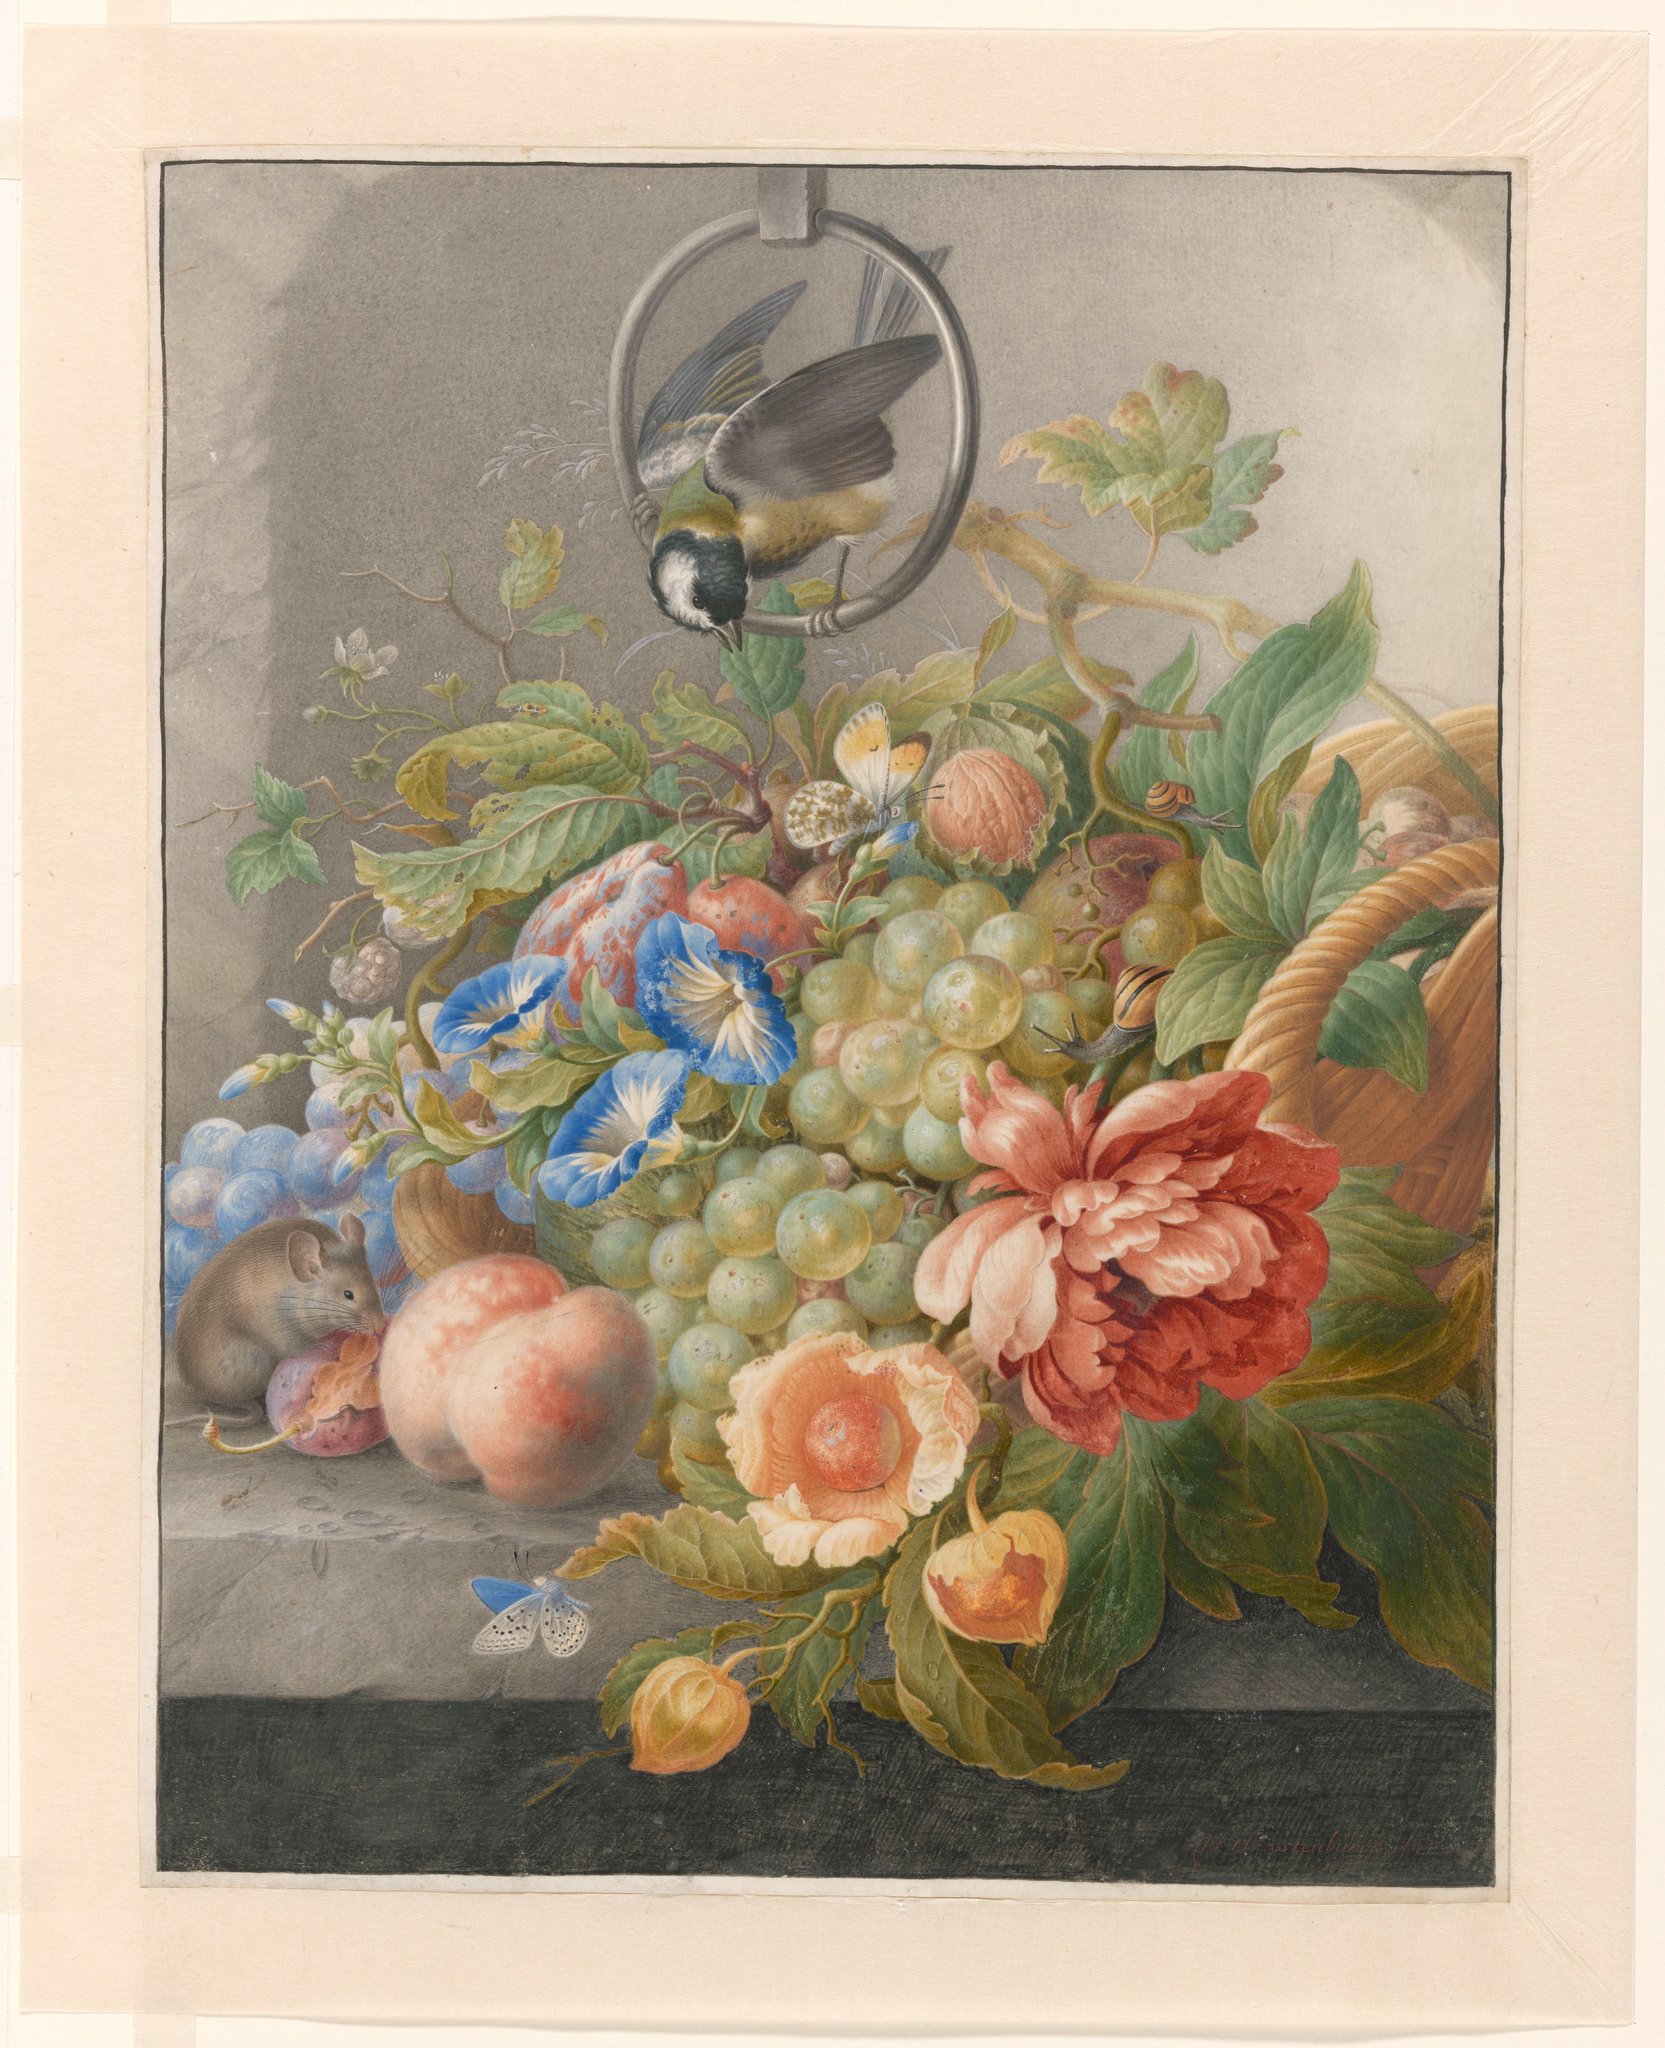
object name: drawing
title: Still Life with Flowers, Fruit, a Great Tit and a Mouse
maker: herman henstenburgh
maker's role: draughtsman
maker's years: 1667-1726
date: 1700-1710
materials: paint, gouache, parchment, watercolor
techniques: brush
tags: still life of plants, flowers and fruit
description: Herman Henstenburg earned his living baking pies, the takeaway meal of the period. He painted his delightful watercolours of flowers, fruit and insects purely for pleasure. Henstenburg developed a special kind of watercolour paint that was so bright and powerful, a contemporary remarked that it rivalled oil paint. His superb still lifes were famous among collectors in his own day, and far beyond his hometown of Hoorn.